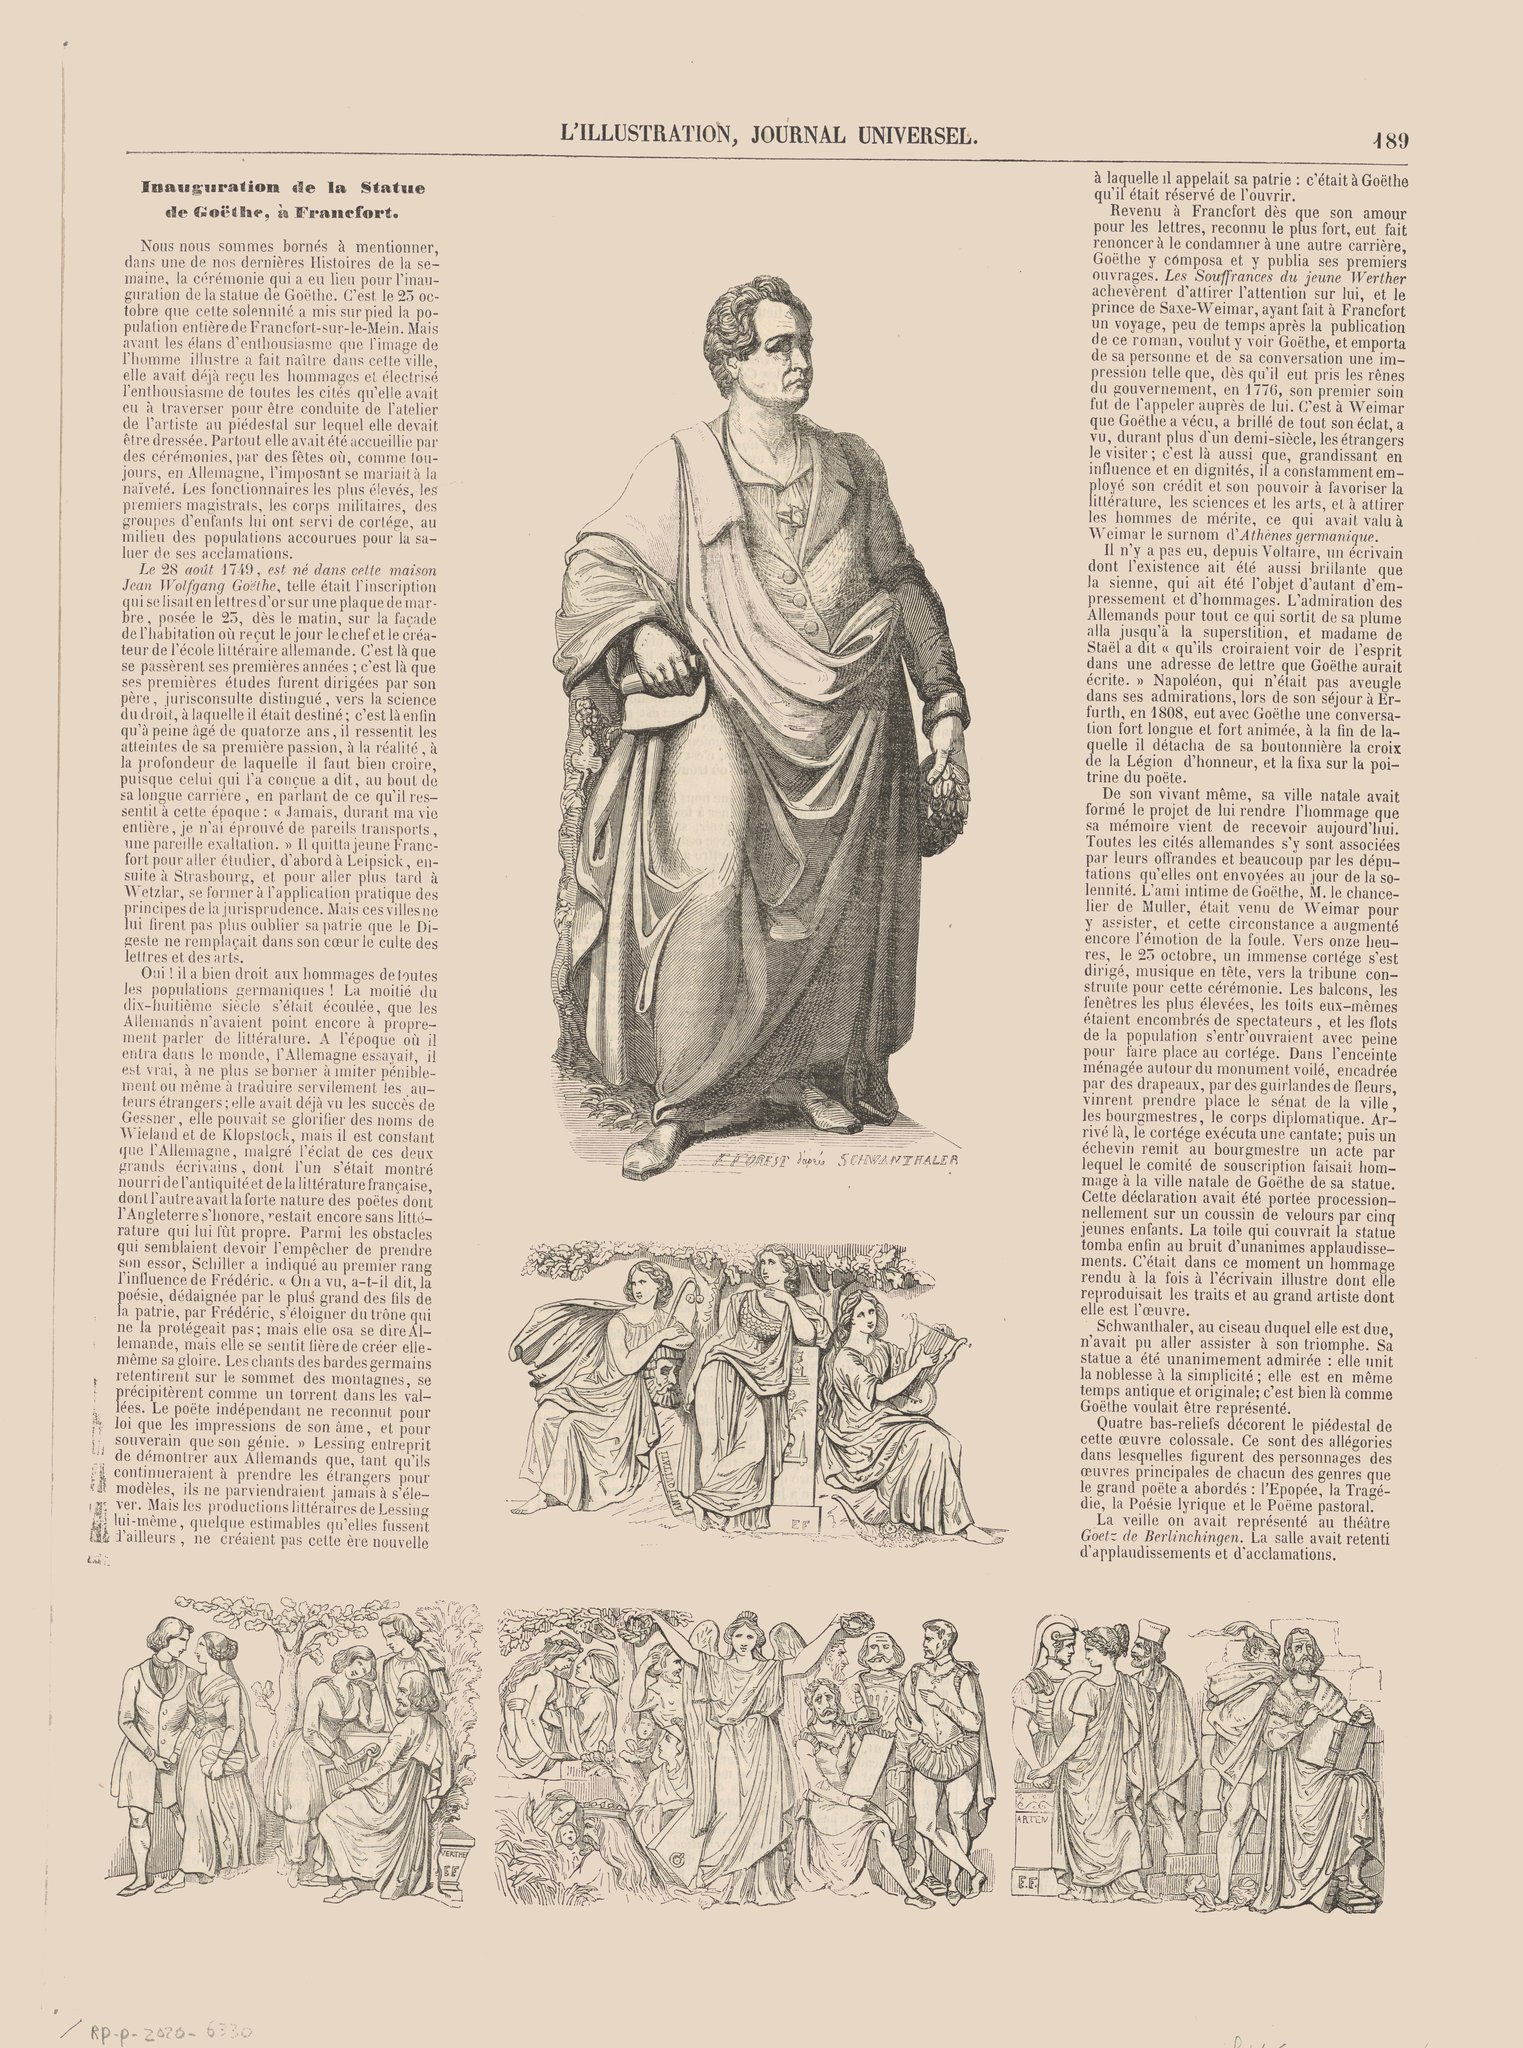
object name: print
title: Sculptuur van Johann Wolfgang von Goethe met vier voorstellingen met personificaties van de kunsten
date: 1880-1920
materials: paper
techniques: letterpress printing, engraving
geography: paris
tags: draughtsman, johann wolfgang von goethe, historical persons, portrait of a writer, sculpture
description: Prent uit: L'Illustration, journal universel 4 (1844), nr. 91, 25 november 1844, p. 189.